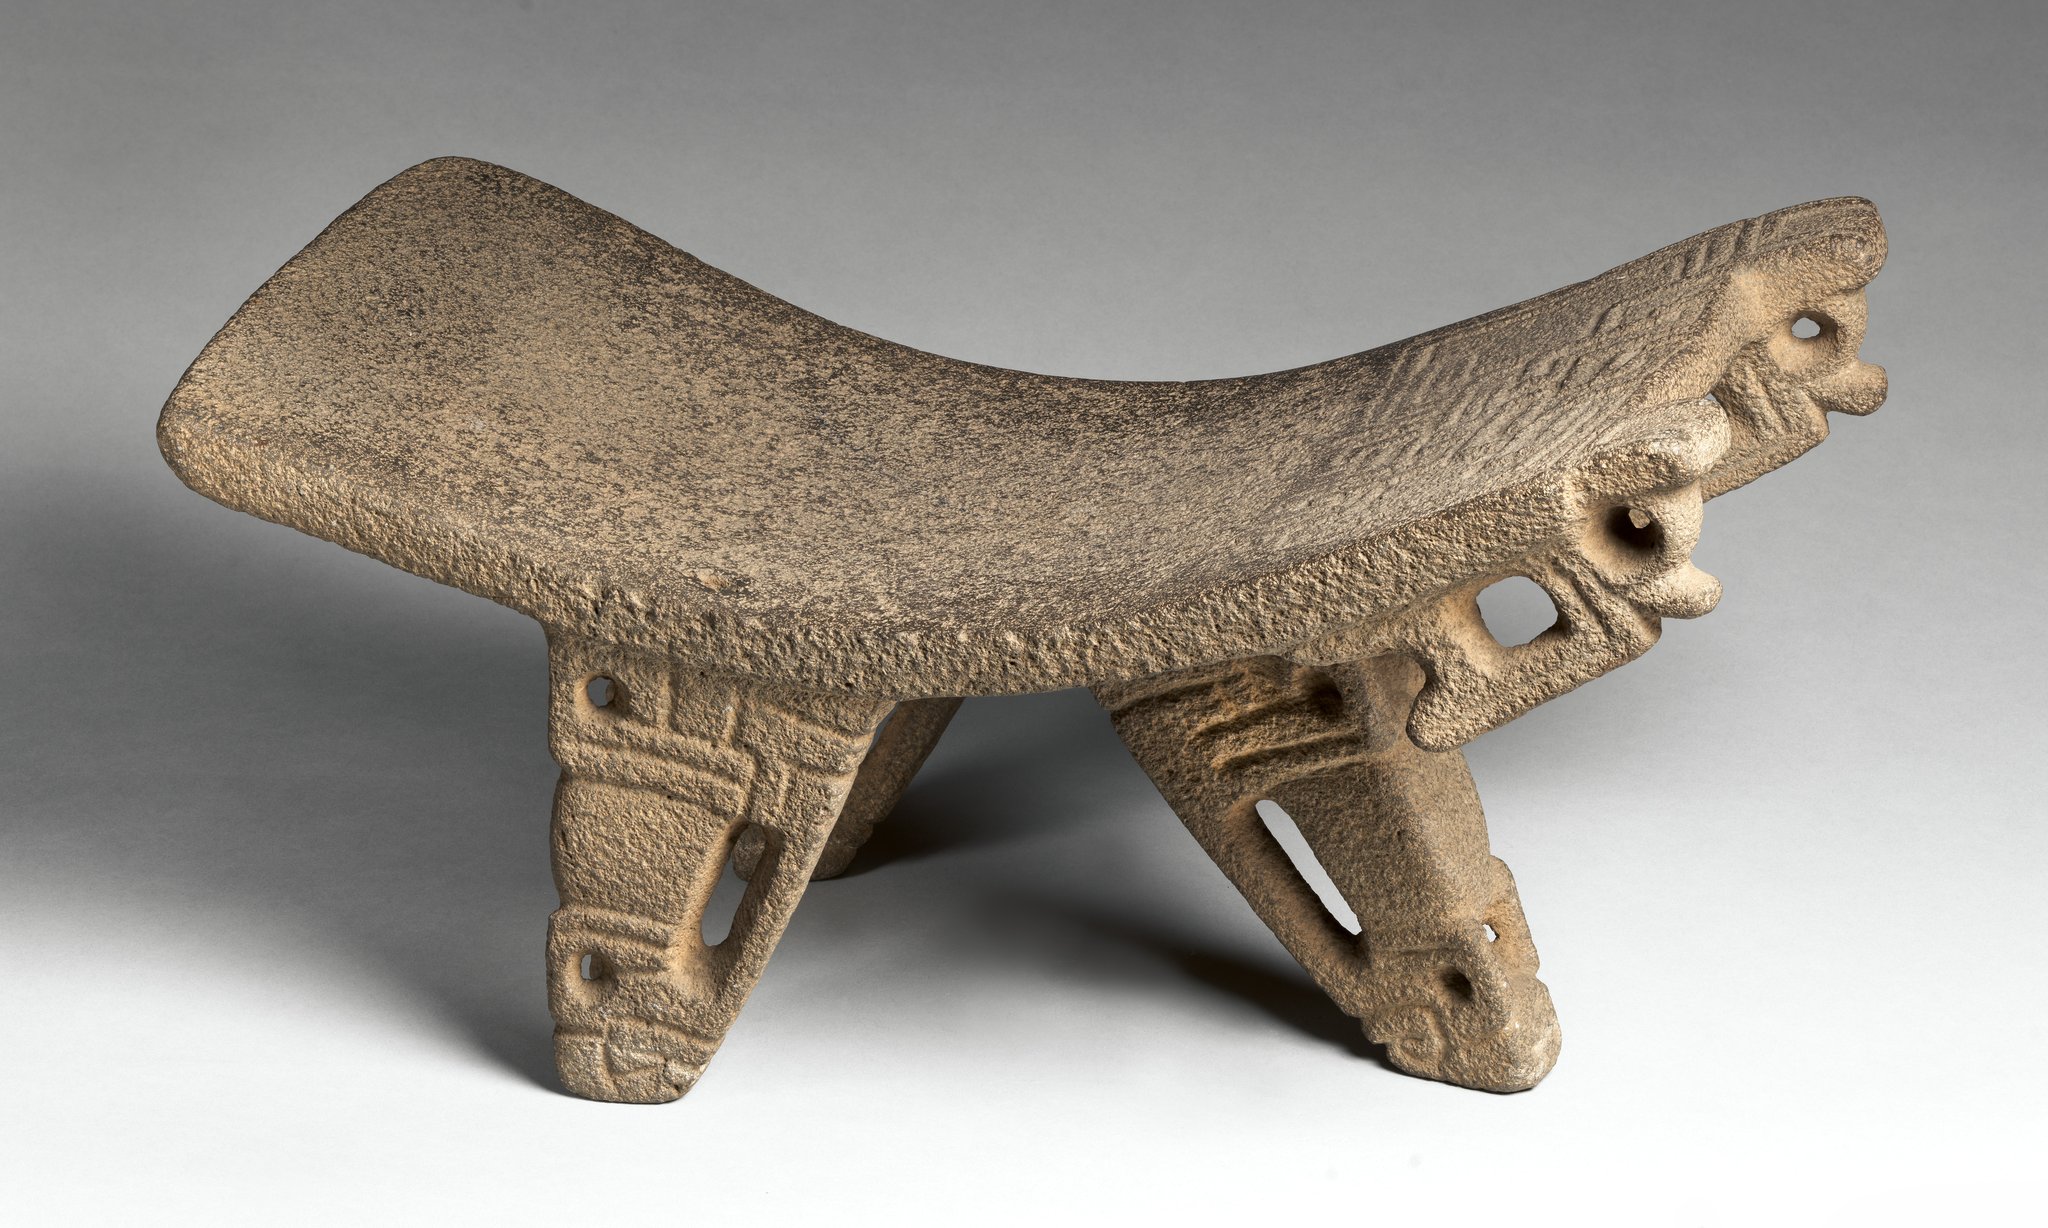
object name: metate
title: Ceremonial Metate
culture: guanacaste-nicoya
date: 301-800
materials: stone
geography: costa rica